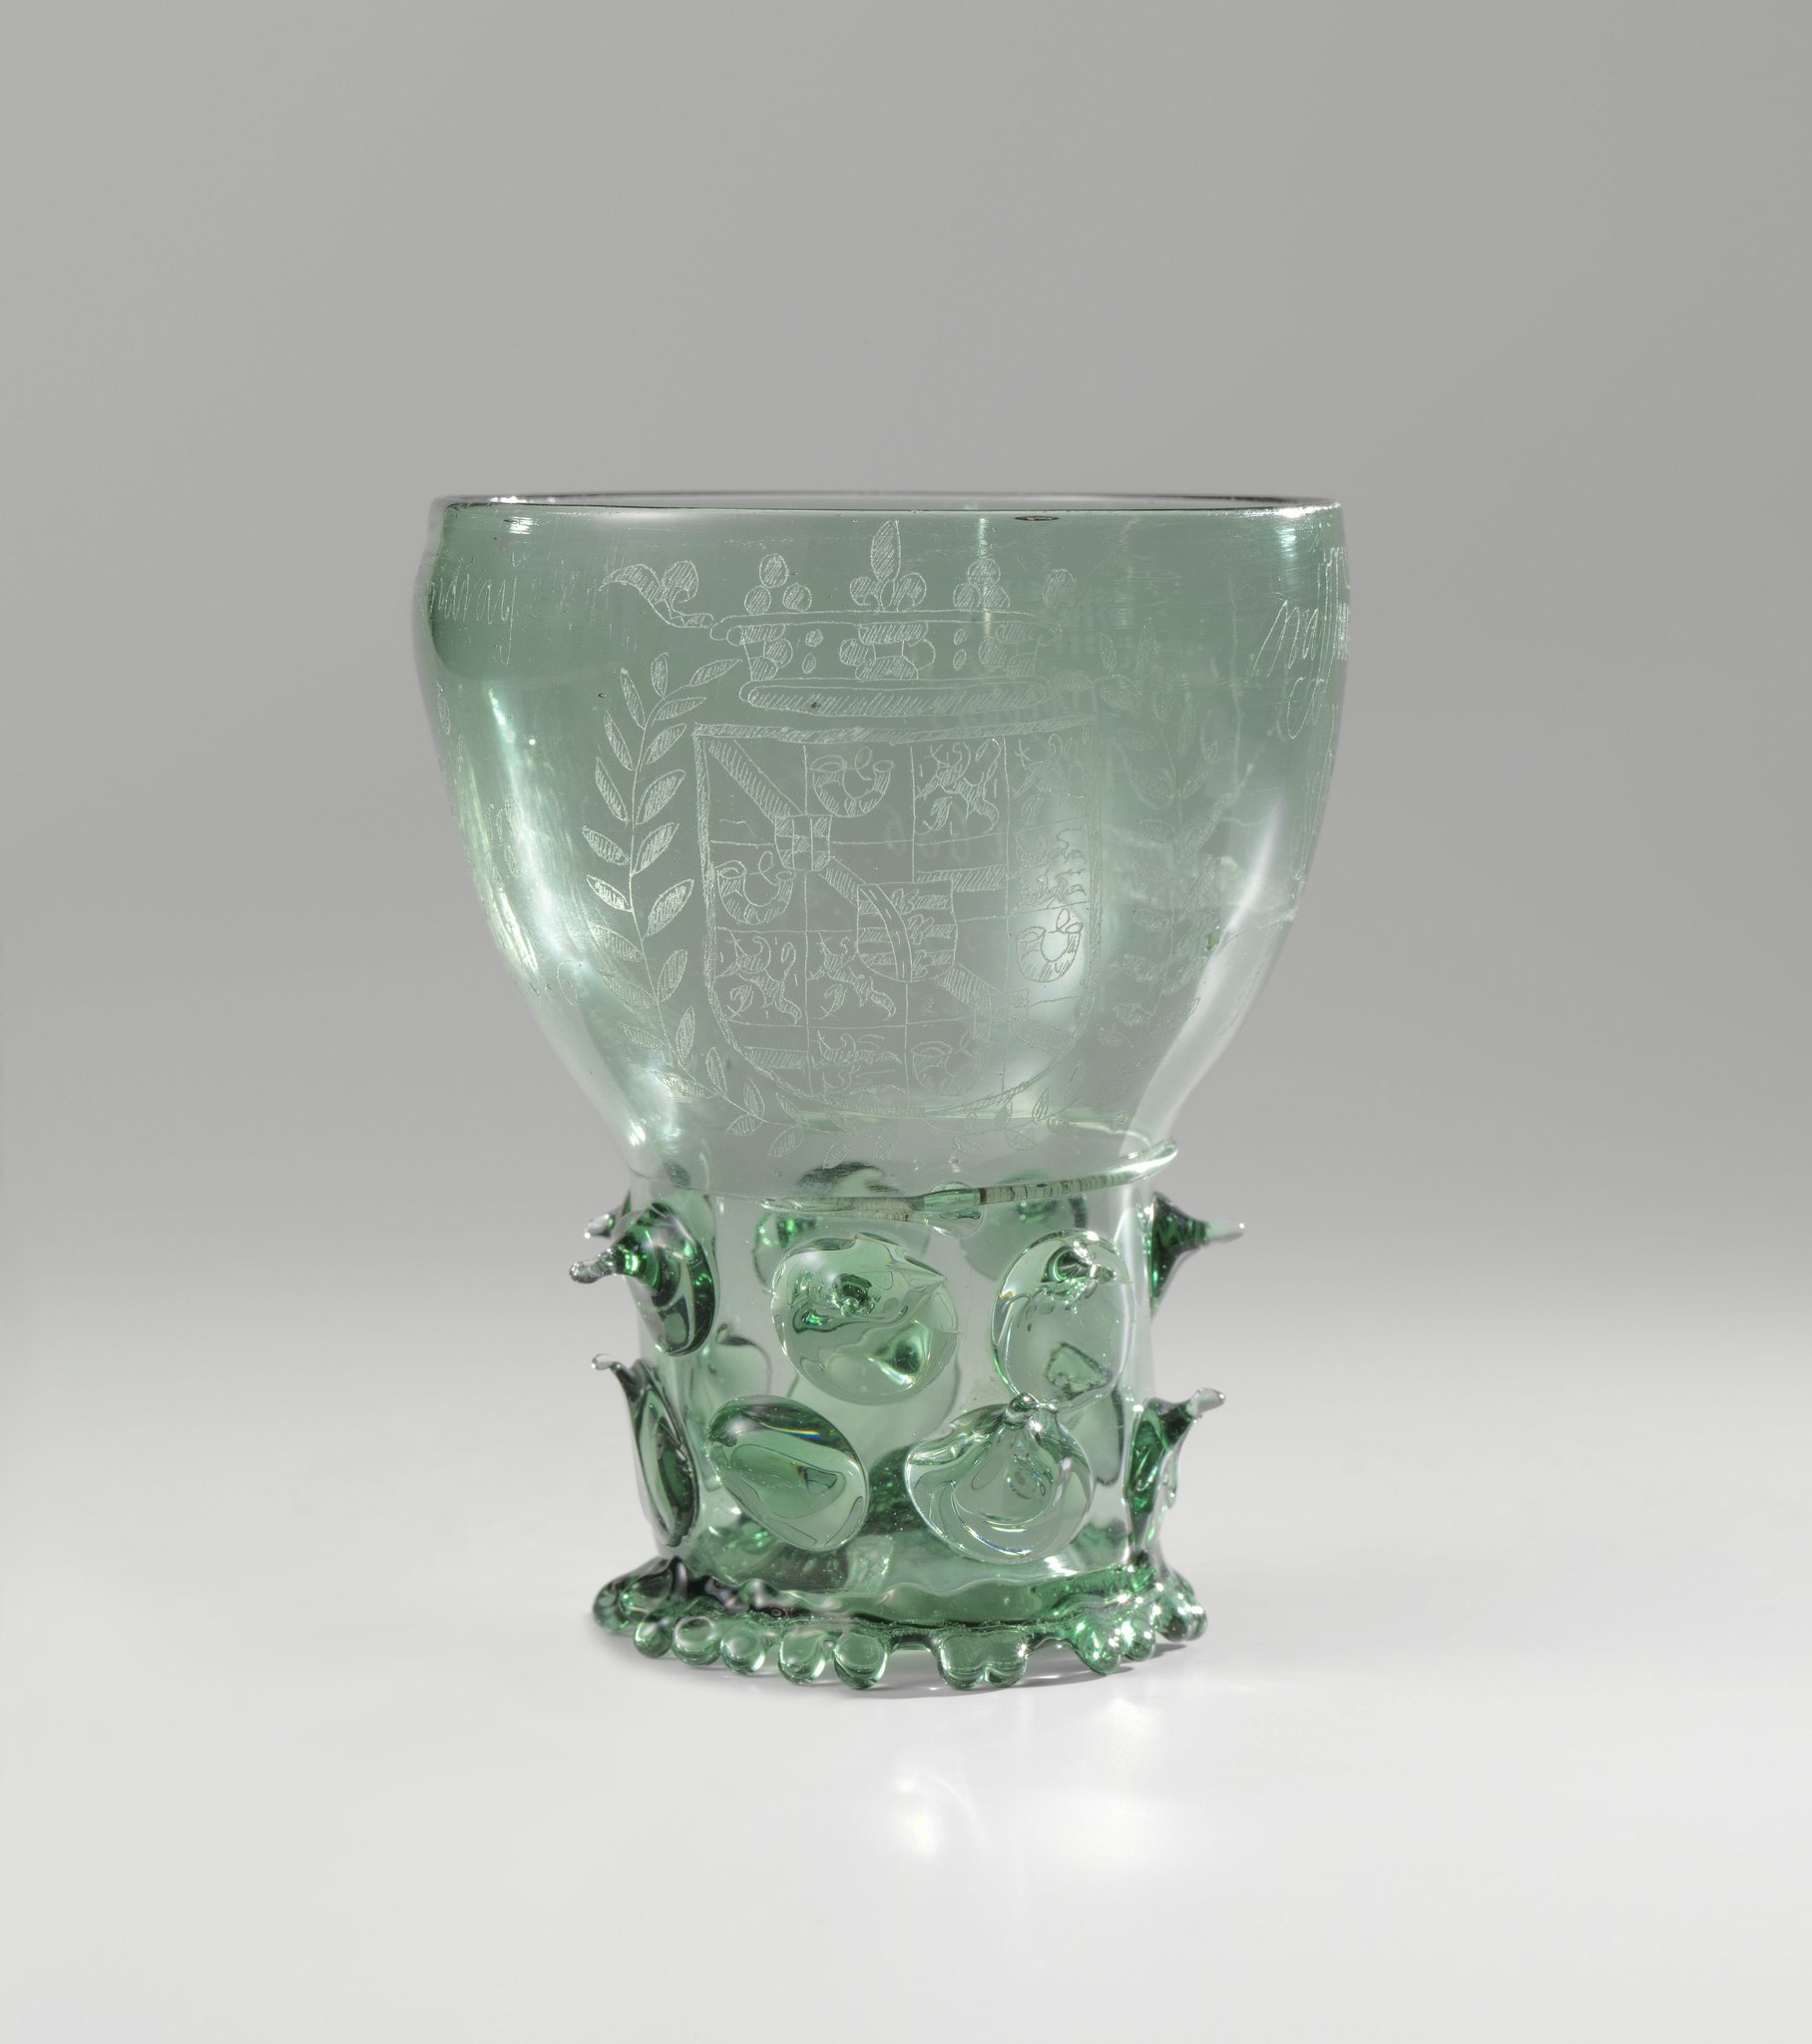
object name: roemer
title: Roemer with the arms and the motto of Prince Maurice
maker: Anonymous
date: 1606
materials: glass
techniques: diamond point engraving, glassblowing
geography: northern netherlands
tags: the hague, maurice (prince of orange), coat of arms (symbol of sovereignty)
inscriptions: date: ‘1606’, inscription: ‘Tandem fit surculus arbor’, inscription: ‘Je maintiendray Nassau’, inscription: ‘Joos parsevael Als deecken’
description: The barren, chopped-down tree engraved on the glass stands for Maurice’s assassinated father, William of Orange. Sprouting from another stump are two twigs: Maurice and his younger brother, Frederick Henry. Maurice’s motto (Tandem fit surculus arbor) reads in translation: ‘In time, the (off)shoot becomes a tree.’ By 1606, when this glass was engraved, Maurice had already racked up many military successes.